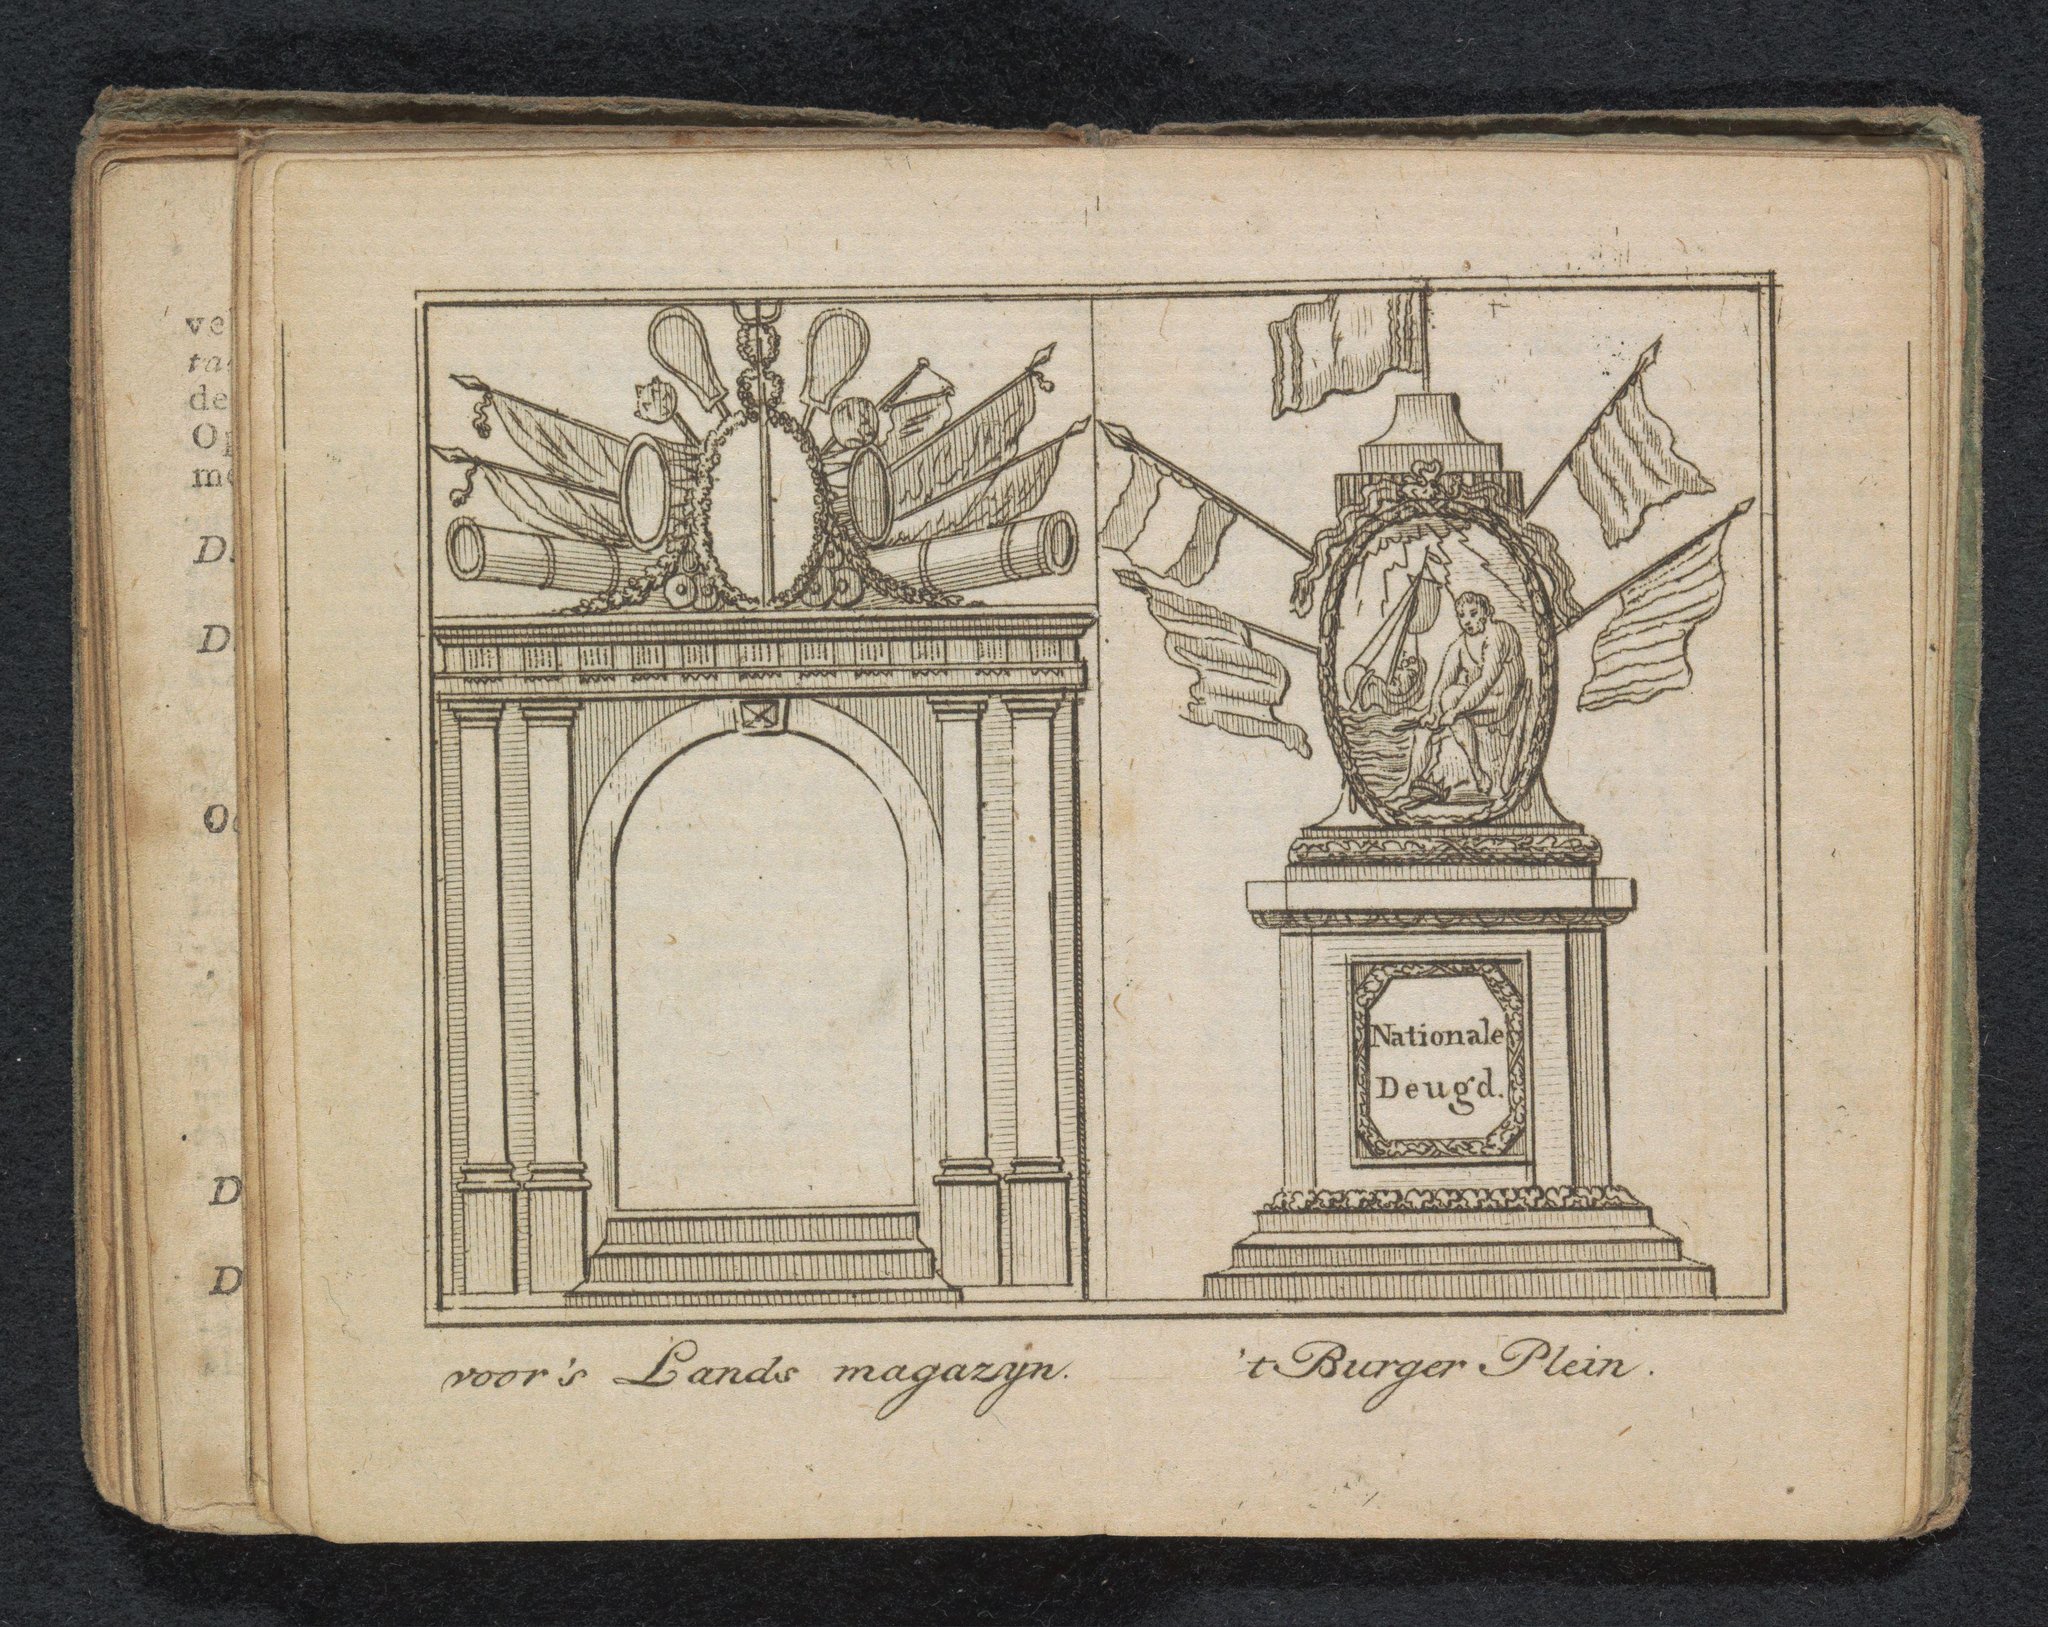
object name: book illustration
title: voor 's Lands magazyn / 't Burger Plein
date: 1795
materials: paper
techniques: etching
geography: netherlands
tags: festivities on events of national importance (+ festive decoration ~ festive activities), alliance with france (1795)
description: Blad met twee platen van de allegorische decoraties opgericht voor 's Lands Zeemagazijn en op het Koningsplein, destijds omgedoopt tot Burgerplein, te Amsterdam bij het Alliantiefeest op 19 juni 1795. Illustratie in het Bataafsche revolutie- en alliantie almanach voor 1796.